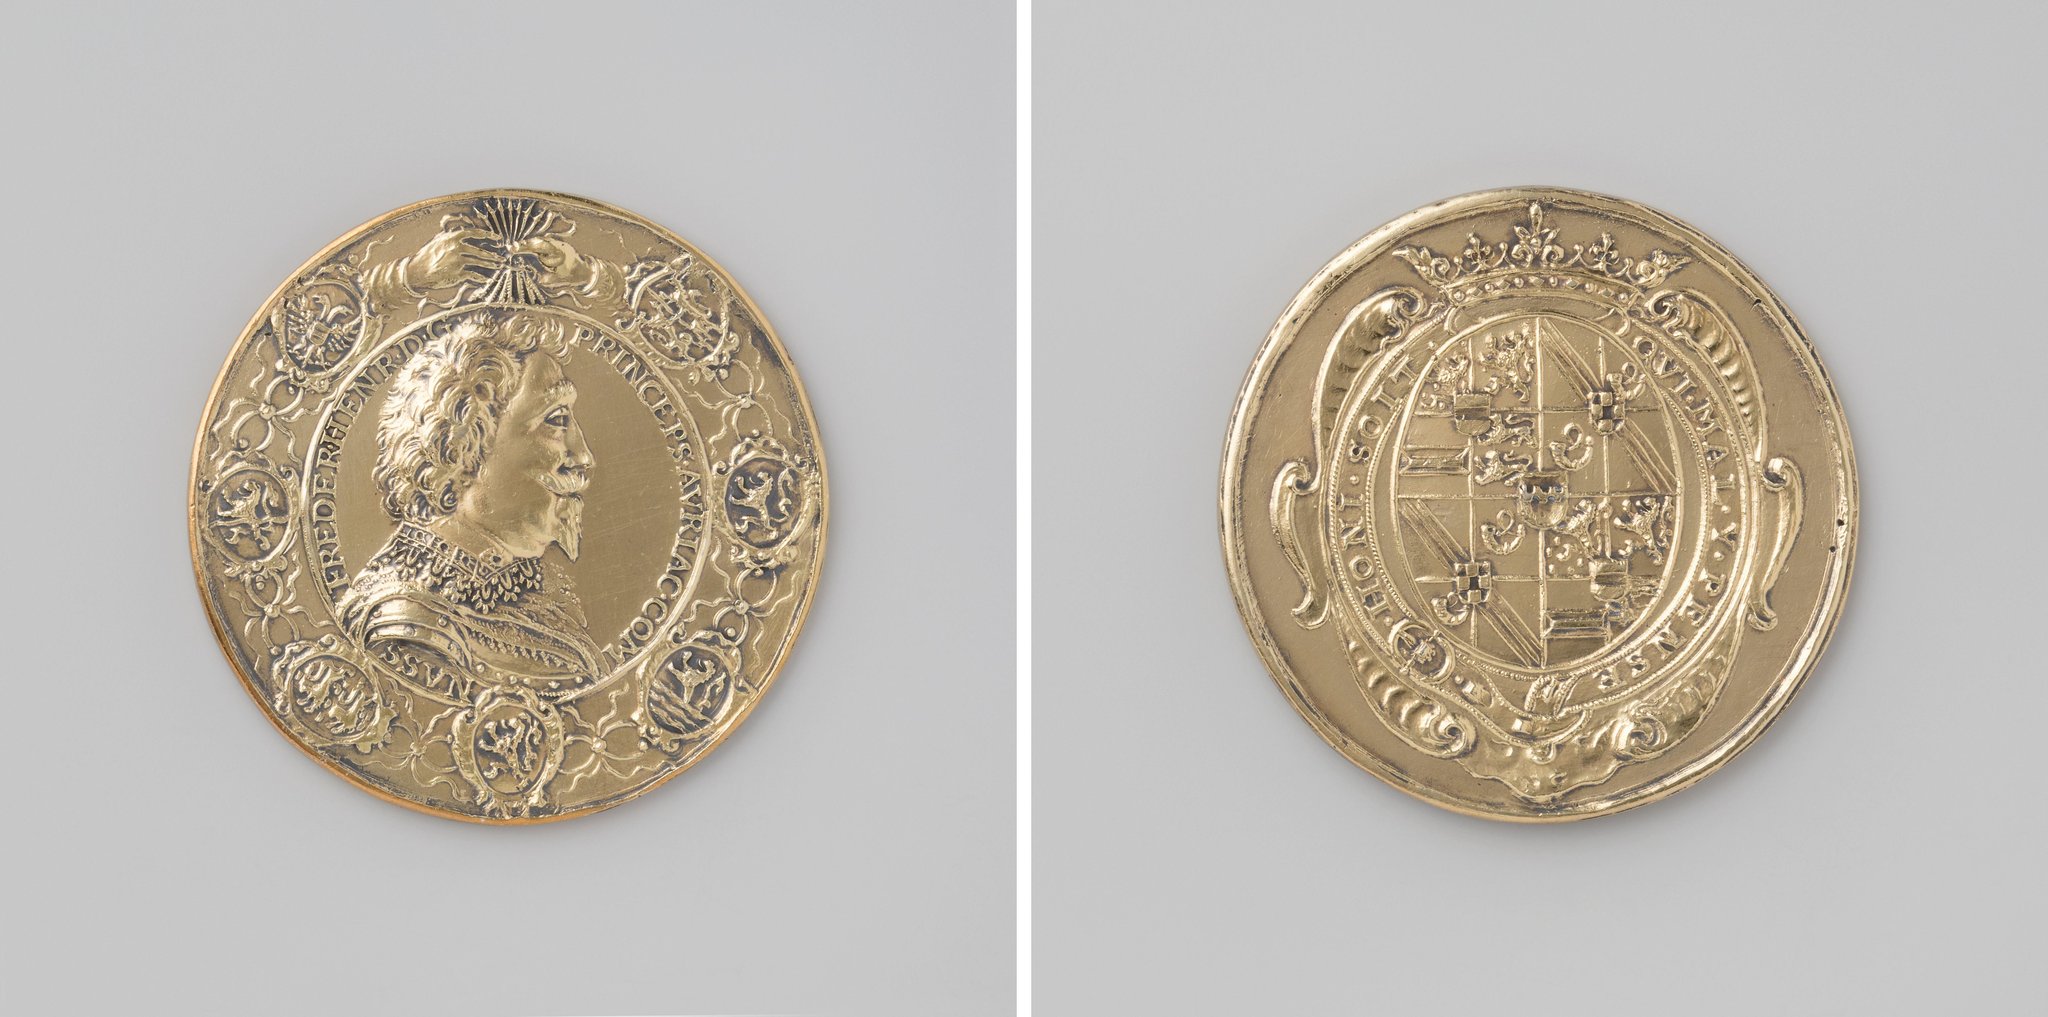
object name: history medal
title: Frederik Hendrik, prins van Oranje-Nassau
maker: aert verbeeck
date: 1627-1647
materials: silver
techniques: gilding, striking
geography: utrecht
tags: frederick henry (prince of orange)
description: Zilveren penning. Voorzijde: borststuk man binnen omschrift en rand met wapenschilden en twee ineengeslagen handen die pijlenbundel vasthouden. Keerzijde: gekroond wapenschild, omhangen met de orde van de kouseband.